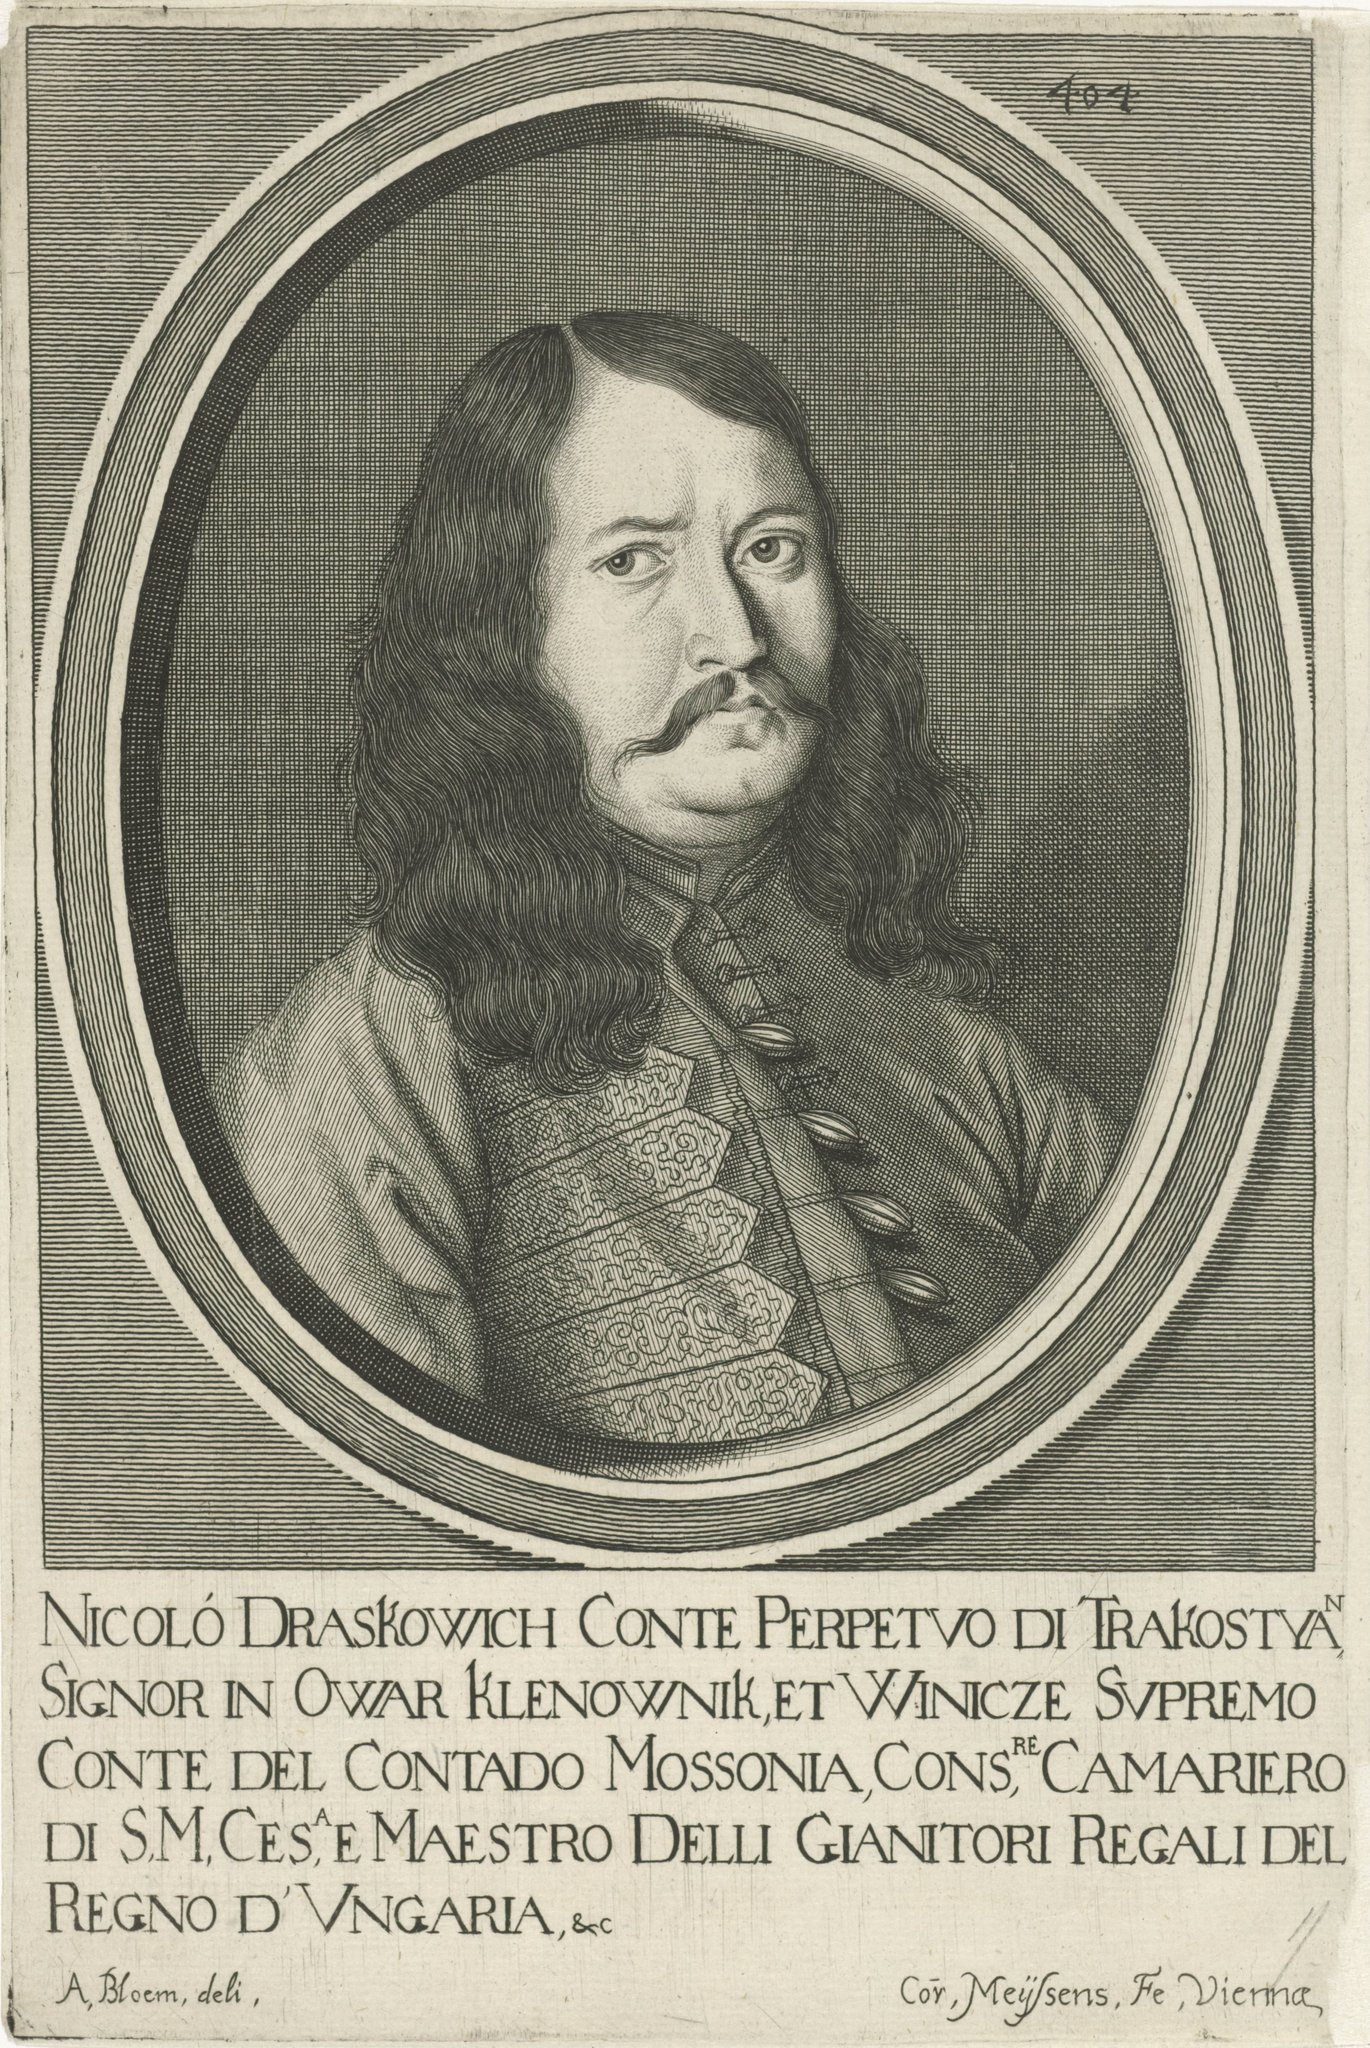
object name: book illustration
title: Portret van Nikola Dras̆ković, graaf van Trakostyáni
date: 1670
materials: paper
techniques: engraving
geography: vienna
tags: earl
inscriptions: collector's mark: Lugt 2228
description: Portret van Nikola Dras̆ković, graaf van Trakostyáni. Onderaan in de marge een vijfregelige tekst in het Italiaans. Rechtsboven genummerd: 404.